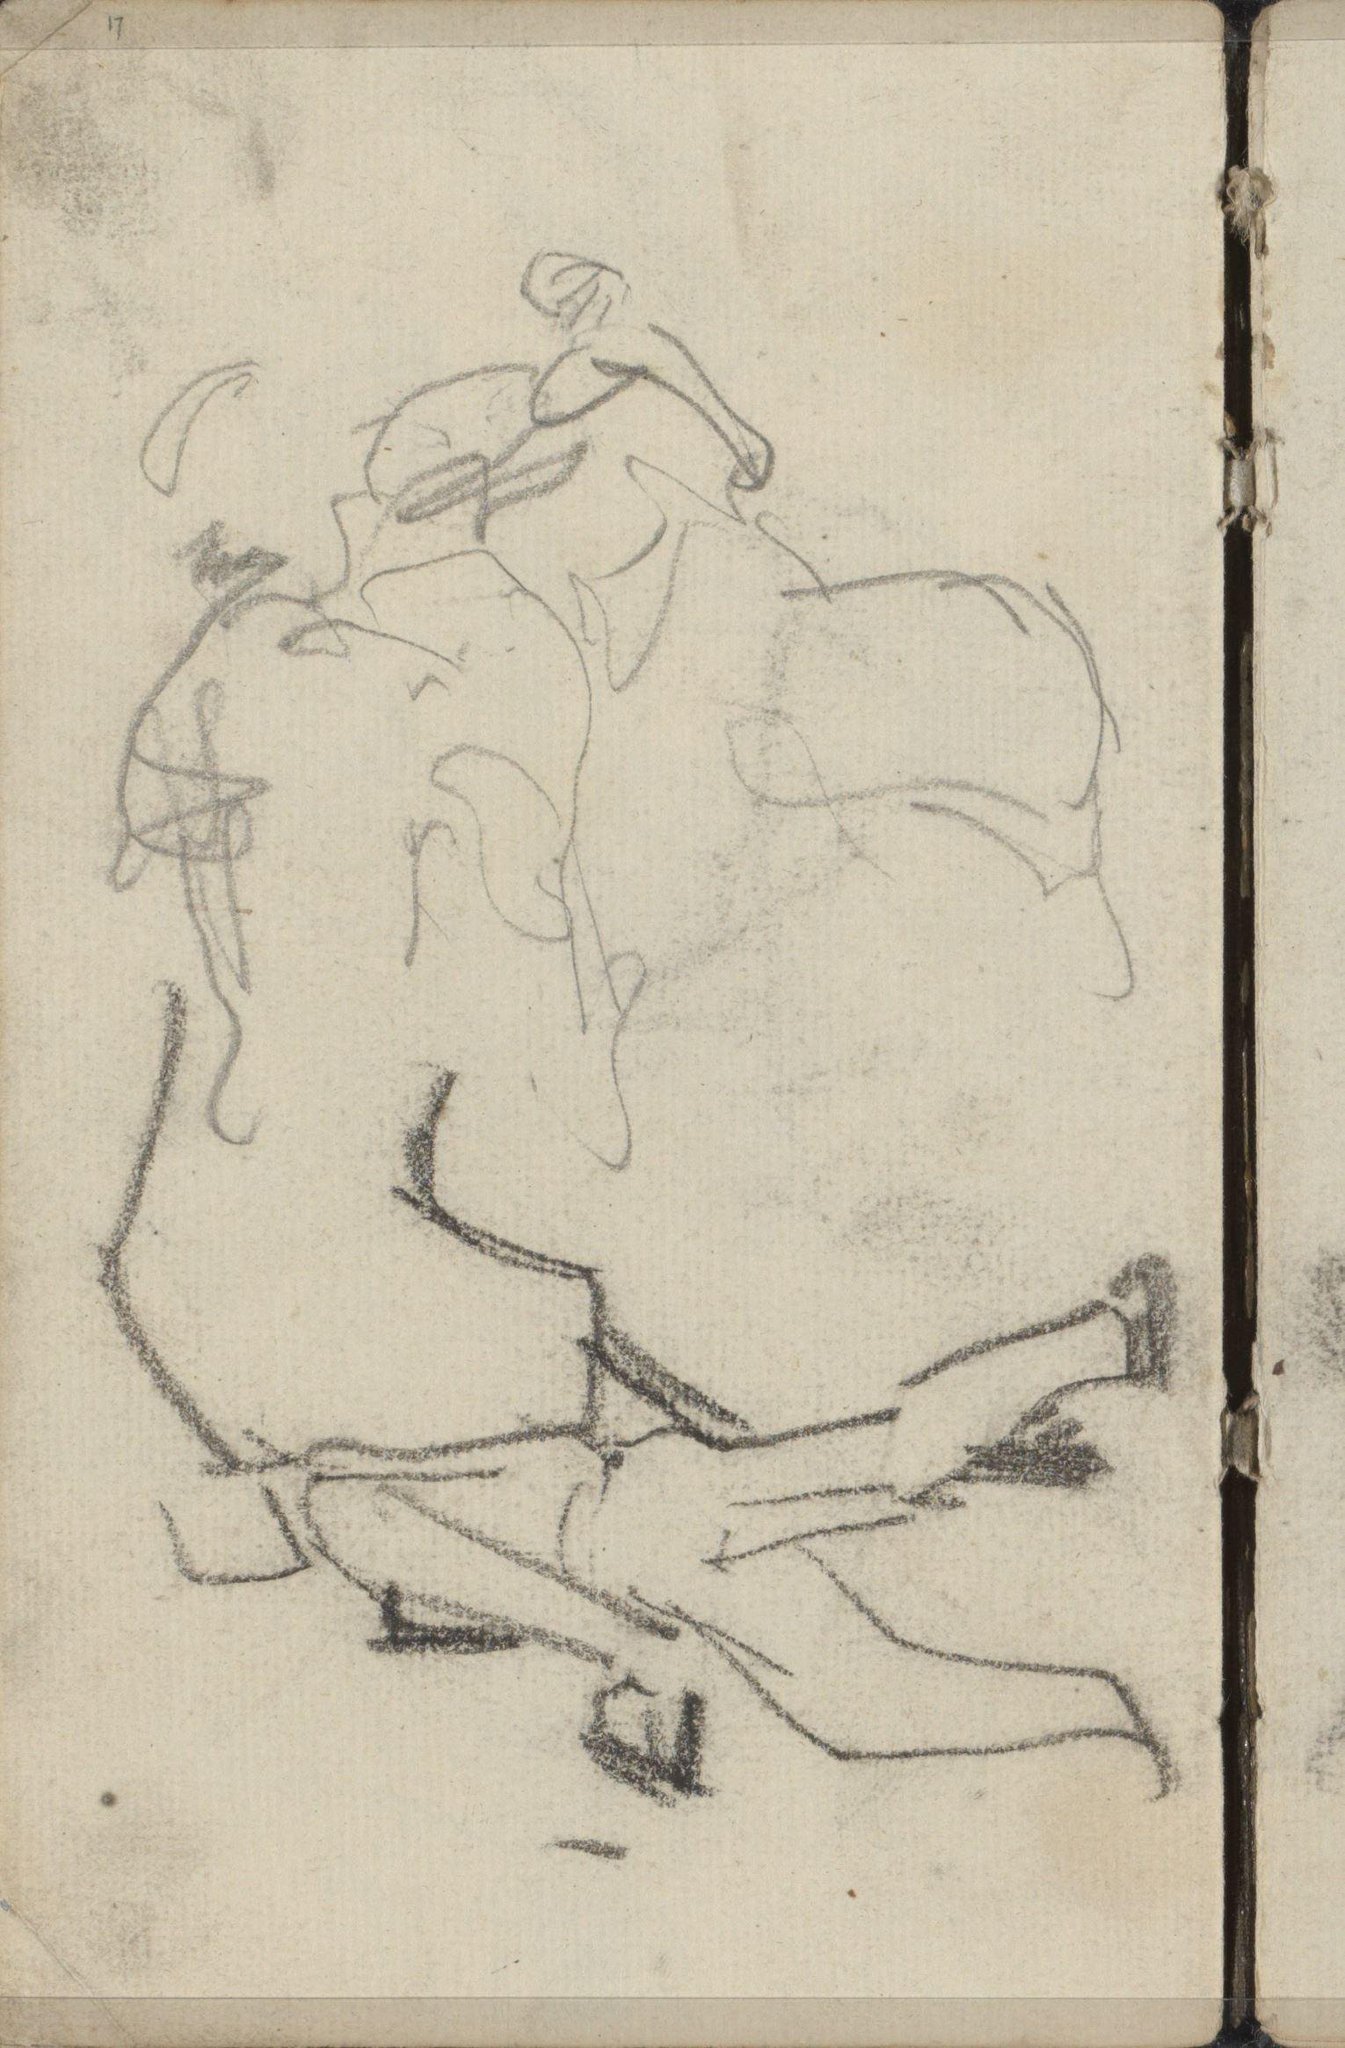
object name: sketchbook leaf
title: Studieblad met figuren en paarden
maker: george hendrik breitner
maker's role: draughtsman, painter, print maker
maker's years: 1857-1923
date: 1883-1885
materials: chalk, paper, pencil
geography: the hague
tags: riding a horse, ass, or mule; rider, horseman, adult man, horse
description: Pagina 17 uit een schetsboek met 17 bladen.